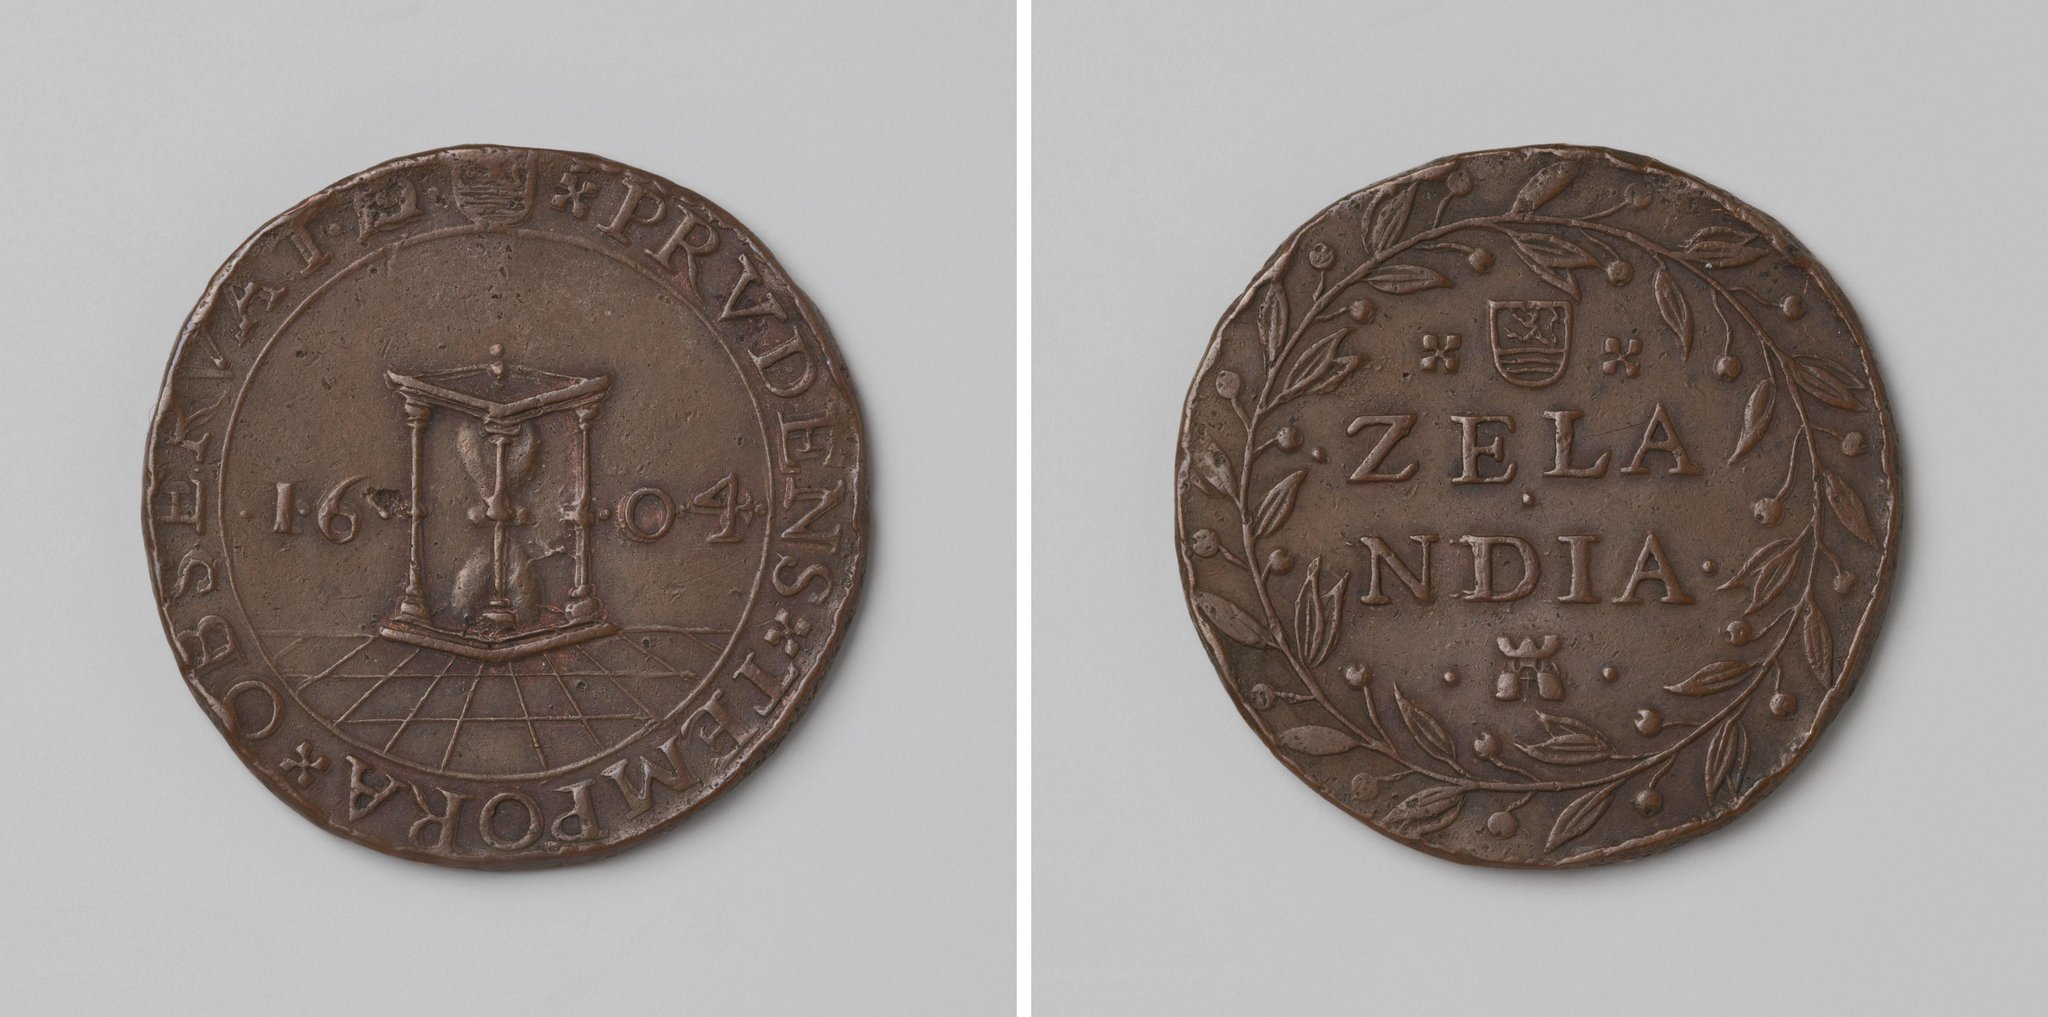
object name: jeton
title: Rust in Zeeland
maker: Anonymous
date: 1604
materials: copper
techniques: striking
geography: middelburg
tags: zeeland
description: Koperen penning. Voorzijde: zandloper tussen jaartal binnen omschrift. Keerzijde: opschrift onder wapenschild boven torentje binnen lauwerkrans